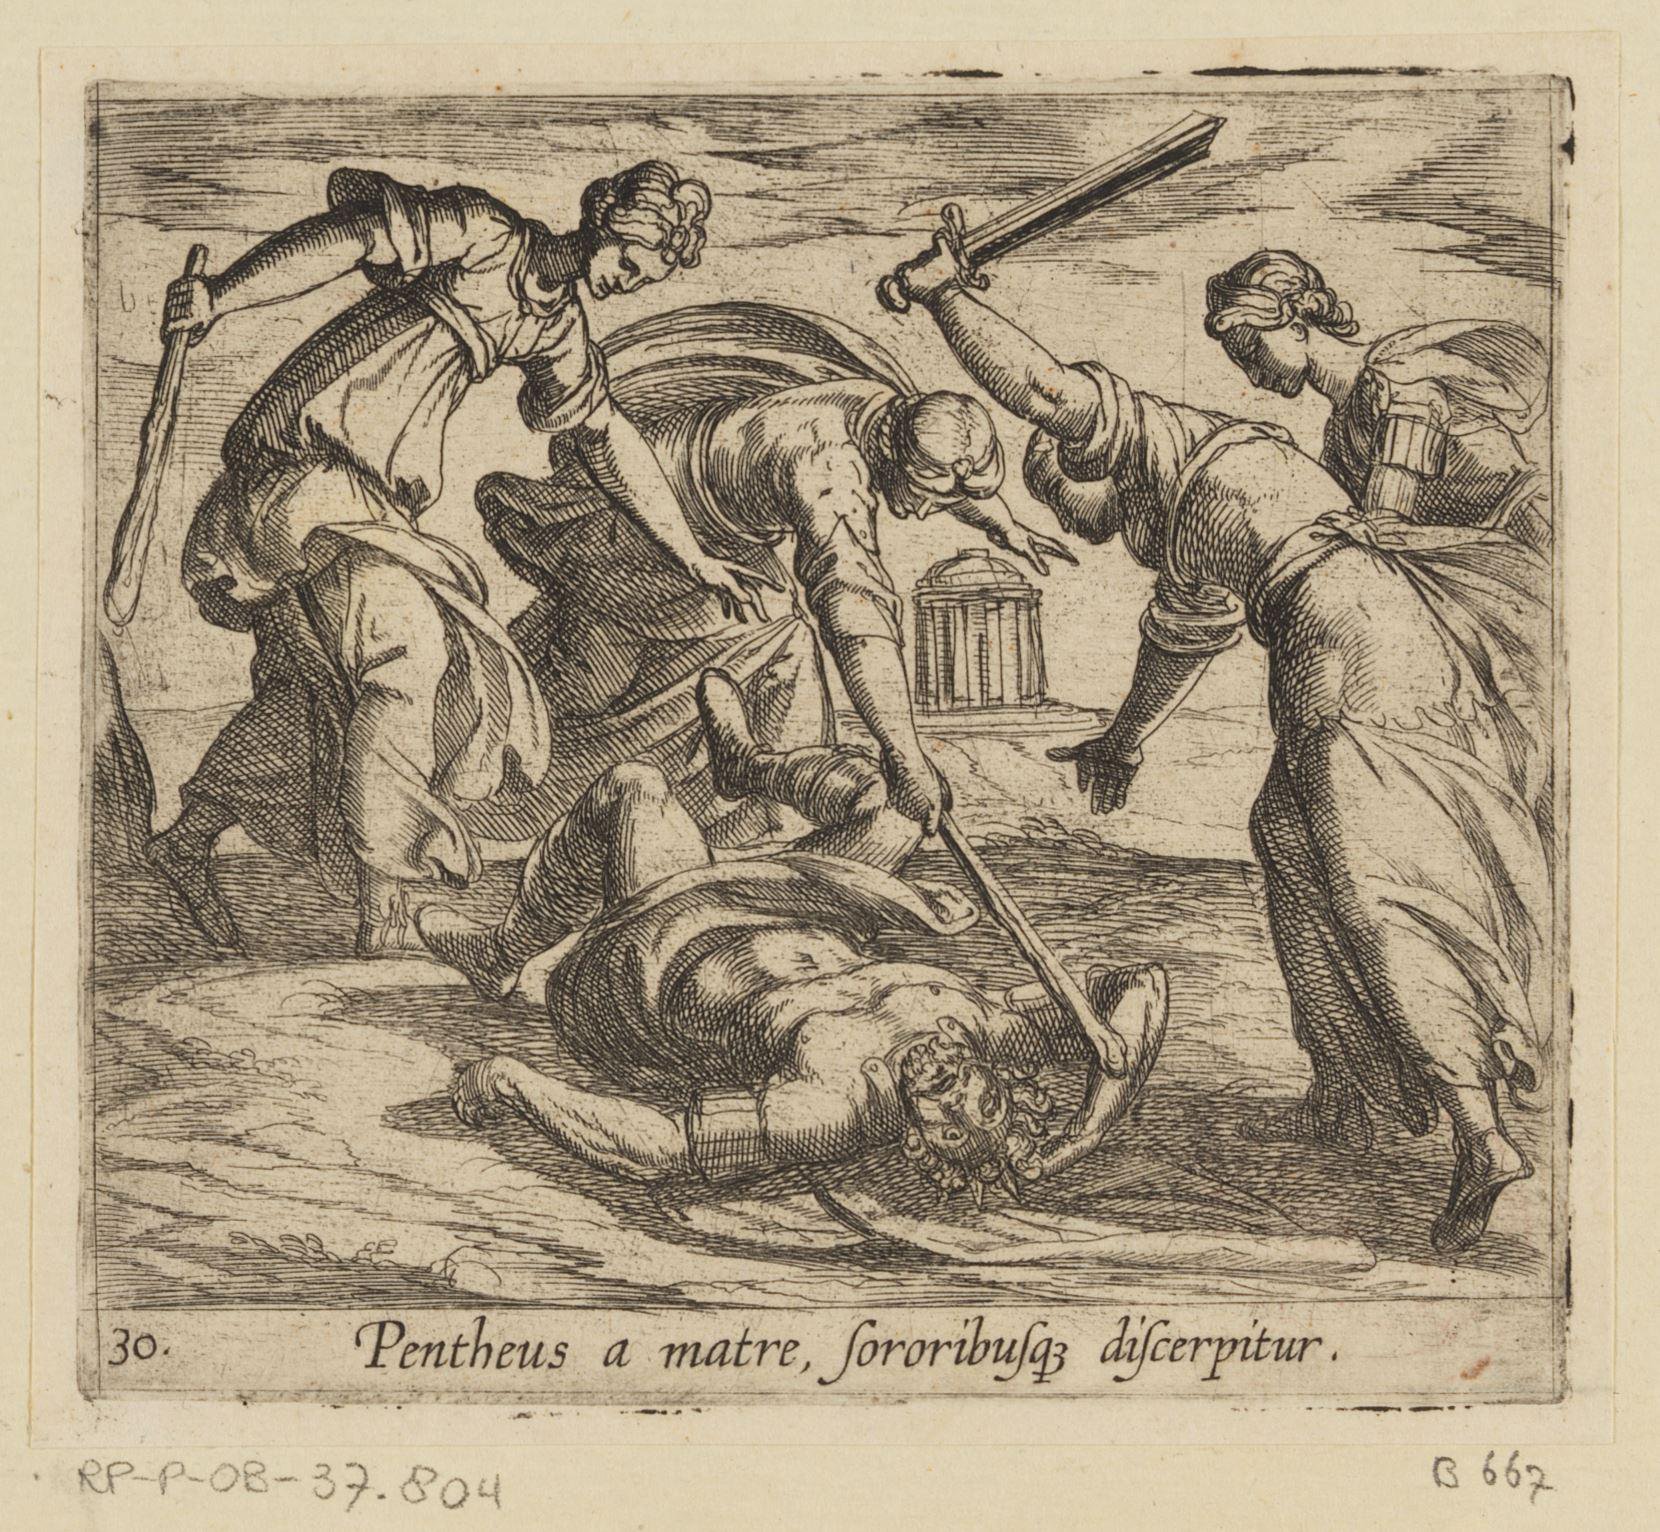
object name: print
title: Metamorfosen van Ovidius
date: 1606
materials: paper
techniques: etching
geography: antwerp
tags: death of pentheus: during a bacchic orgy he is torn to pieces by his mother agave and other women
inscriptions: collector's mark: Lugt 240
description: Tijdens een Bacchische orgie wordt Pentheus doodgeslagen door zijn moeder Agave en andere vrouwen. Titel in het Latijn in ondermarge.